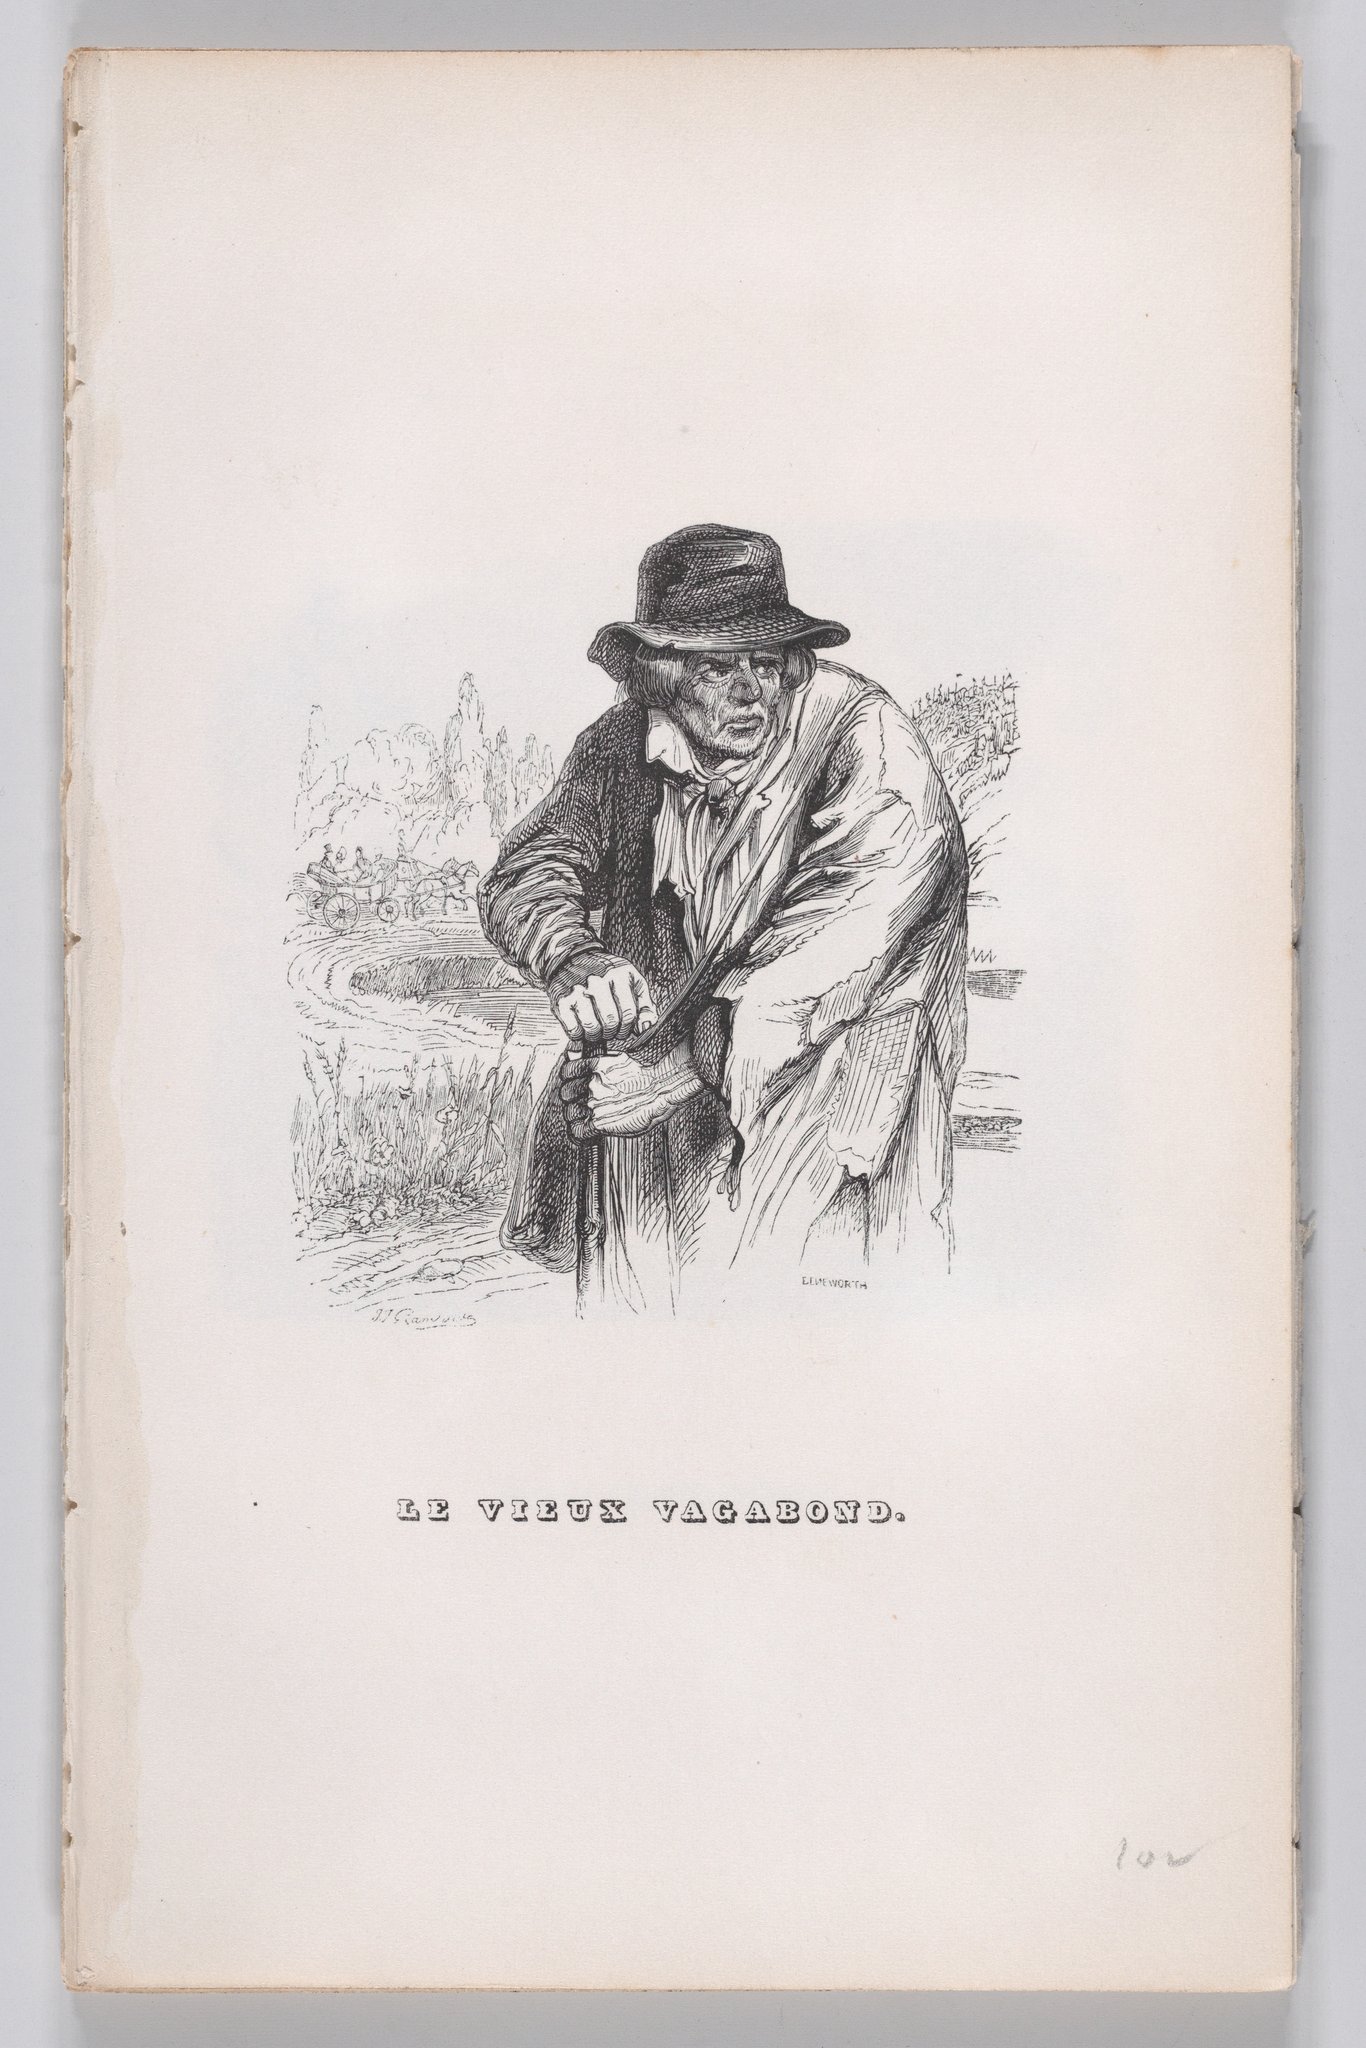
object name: print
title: The Old Vagabond, from "The Complete Works of Béranger"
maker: j. j. grandville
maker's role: illustrator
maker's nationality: french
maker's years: 1803-1847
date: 1836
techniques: engraving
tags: men